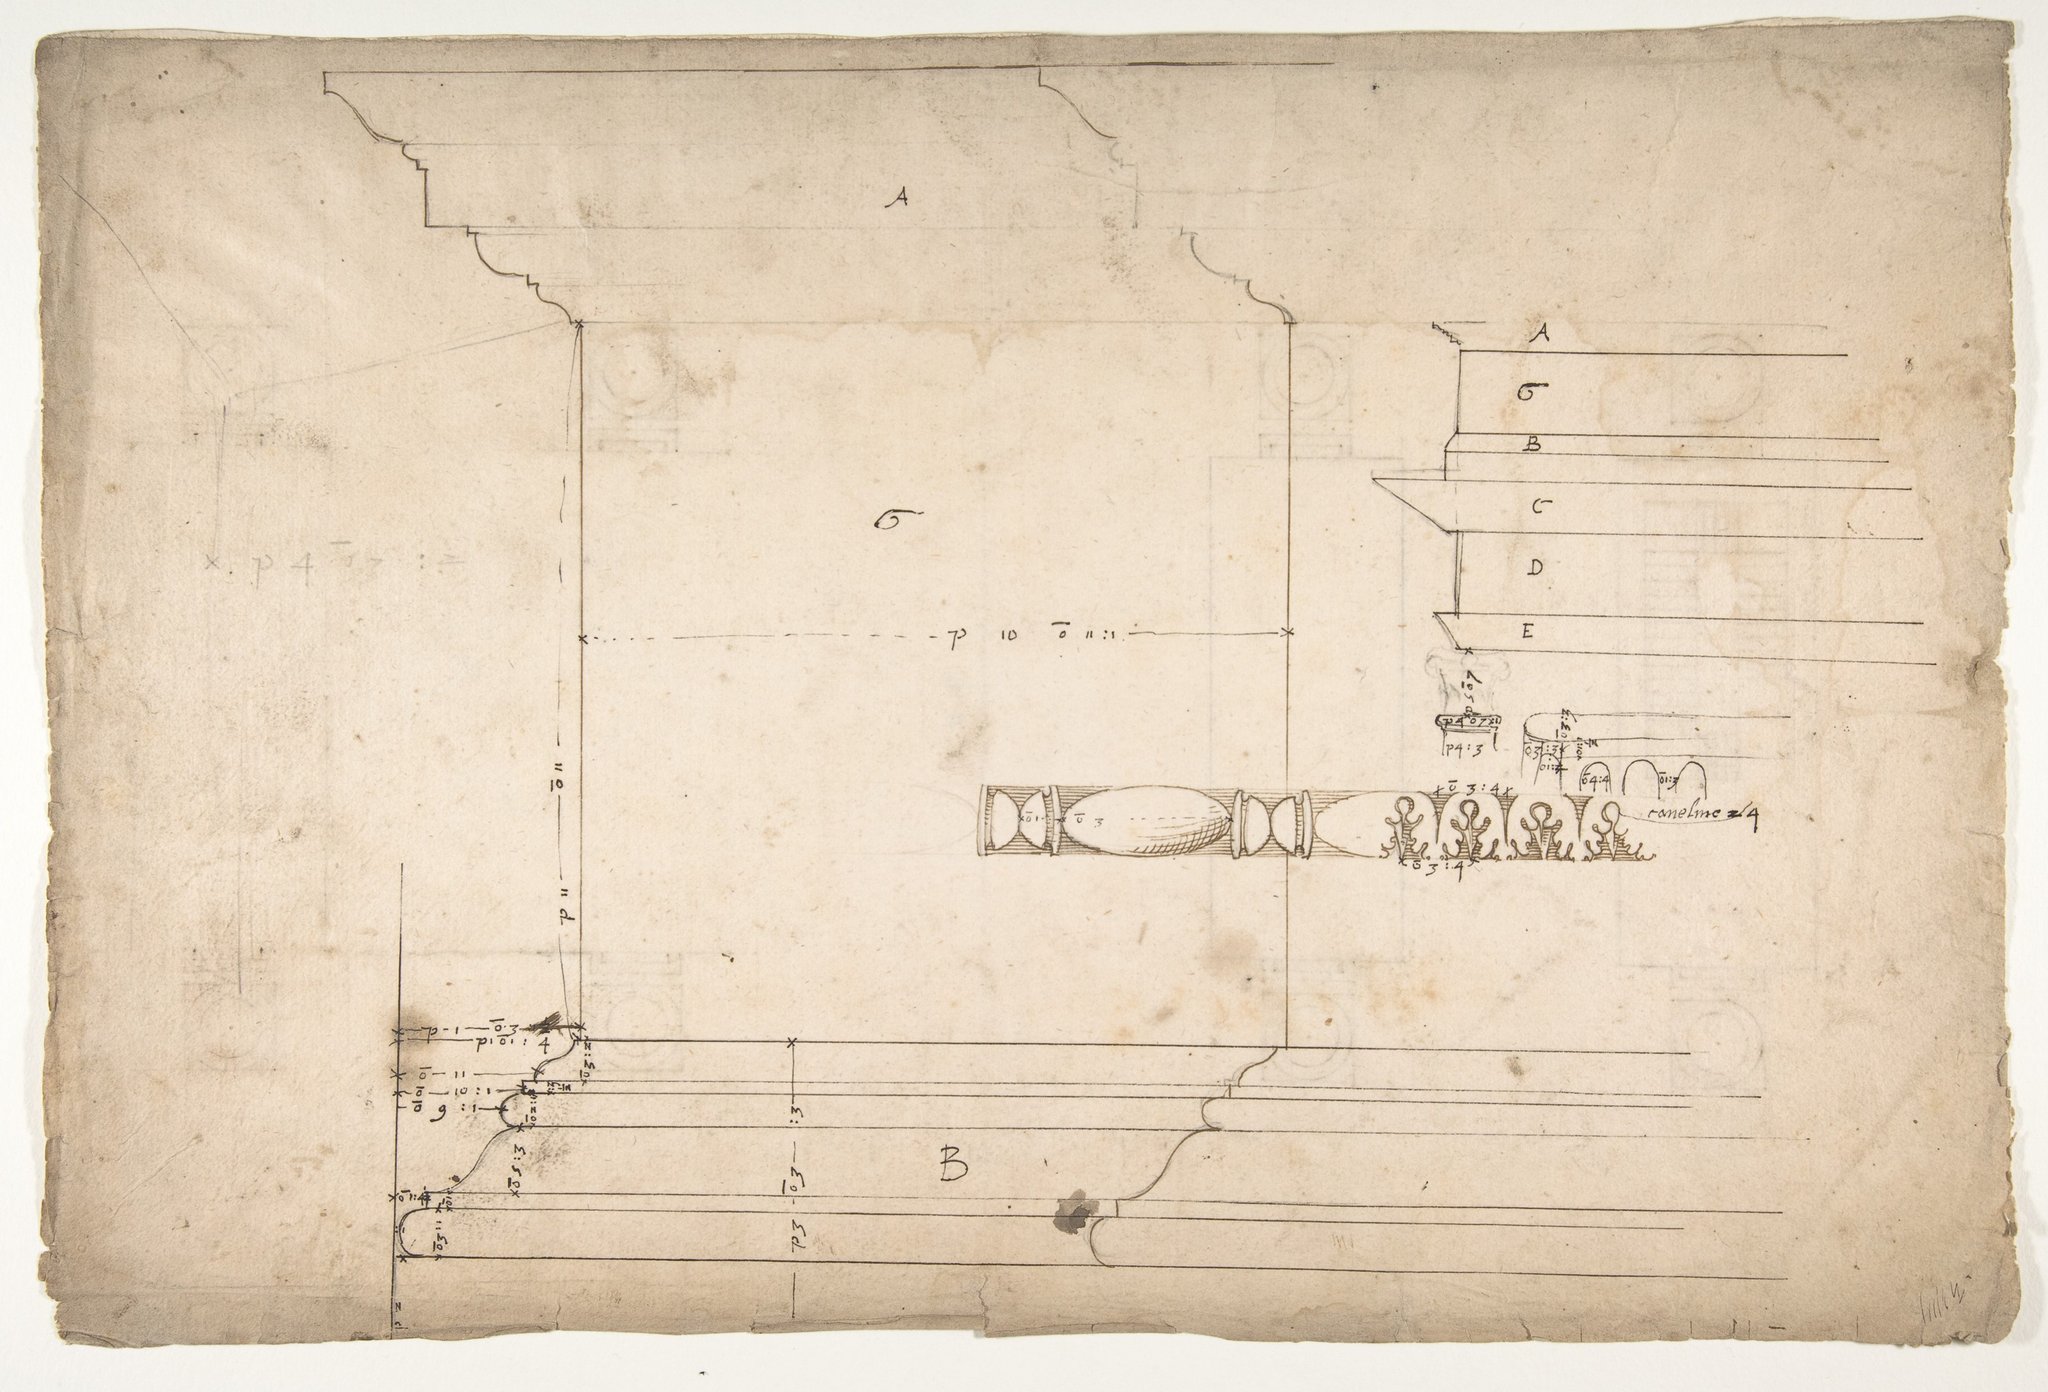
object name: collection ornament architecture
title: Forum of Nerva, colonnade, profiles of attic and entablature, architrave and column detail (recto) Arch of Constantine, plan (verso)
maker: anonymous, french, 16th century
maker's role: draftsman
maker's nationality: french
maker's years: 1500-1600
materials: chalk, ink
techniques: incising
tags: architecture